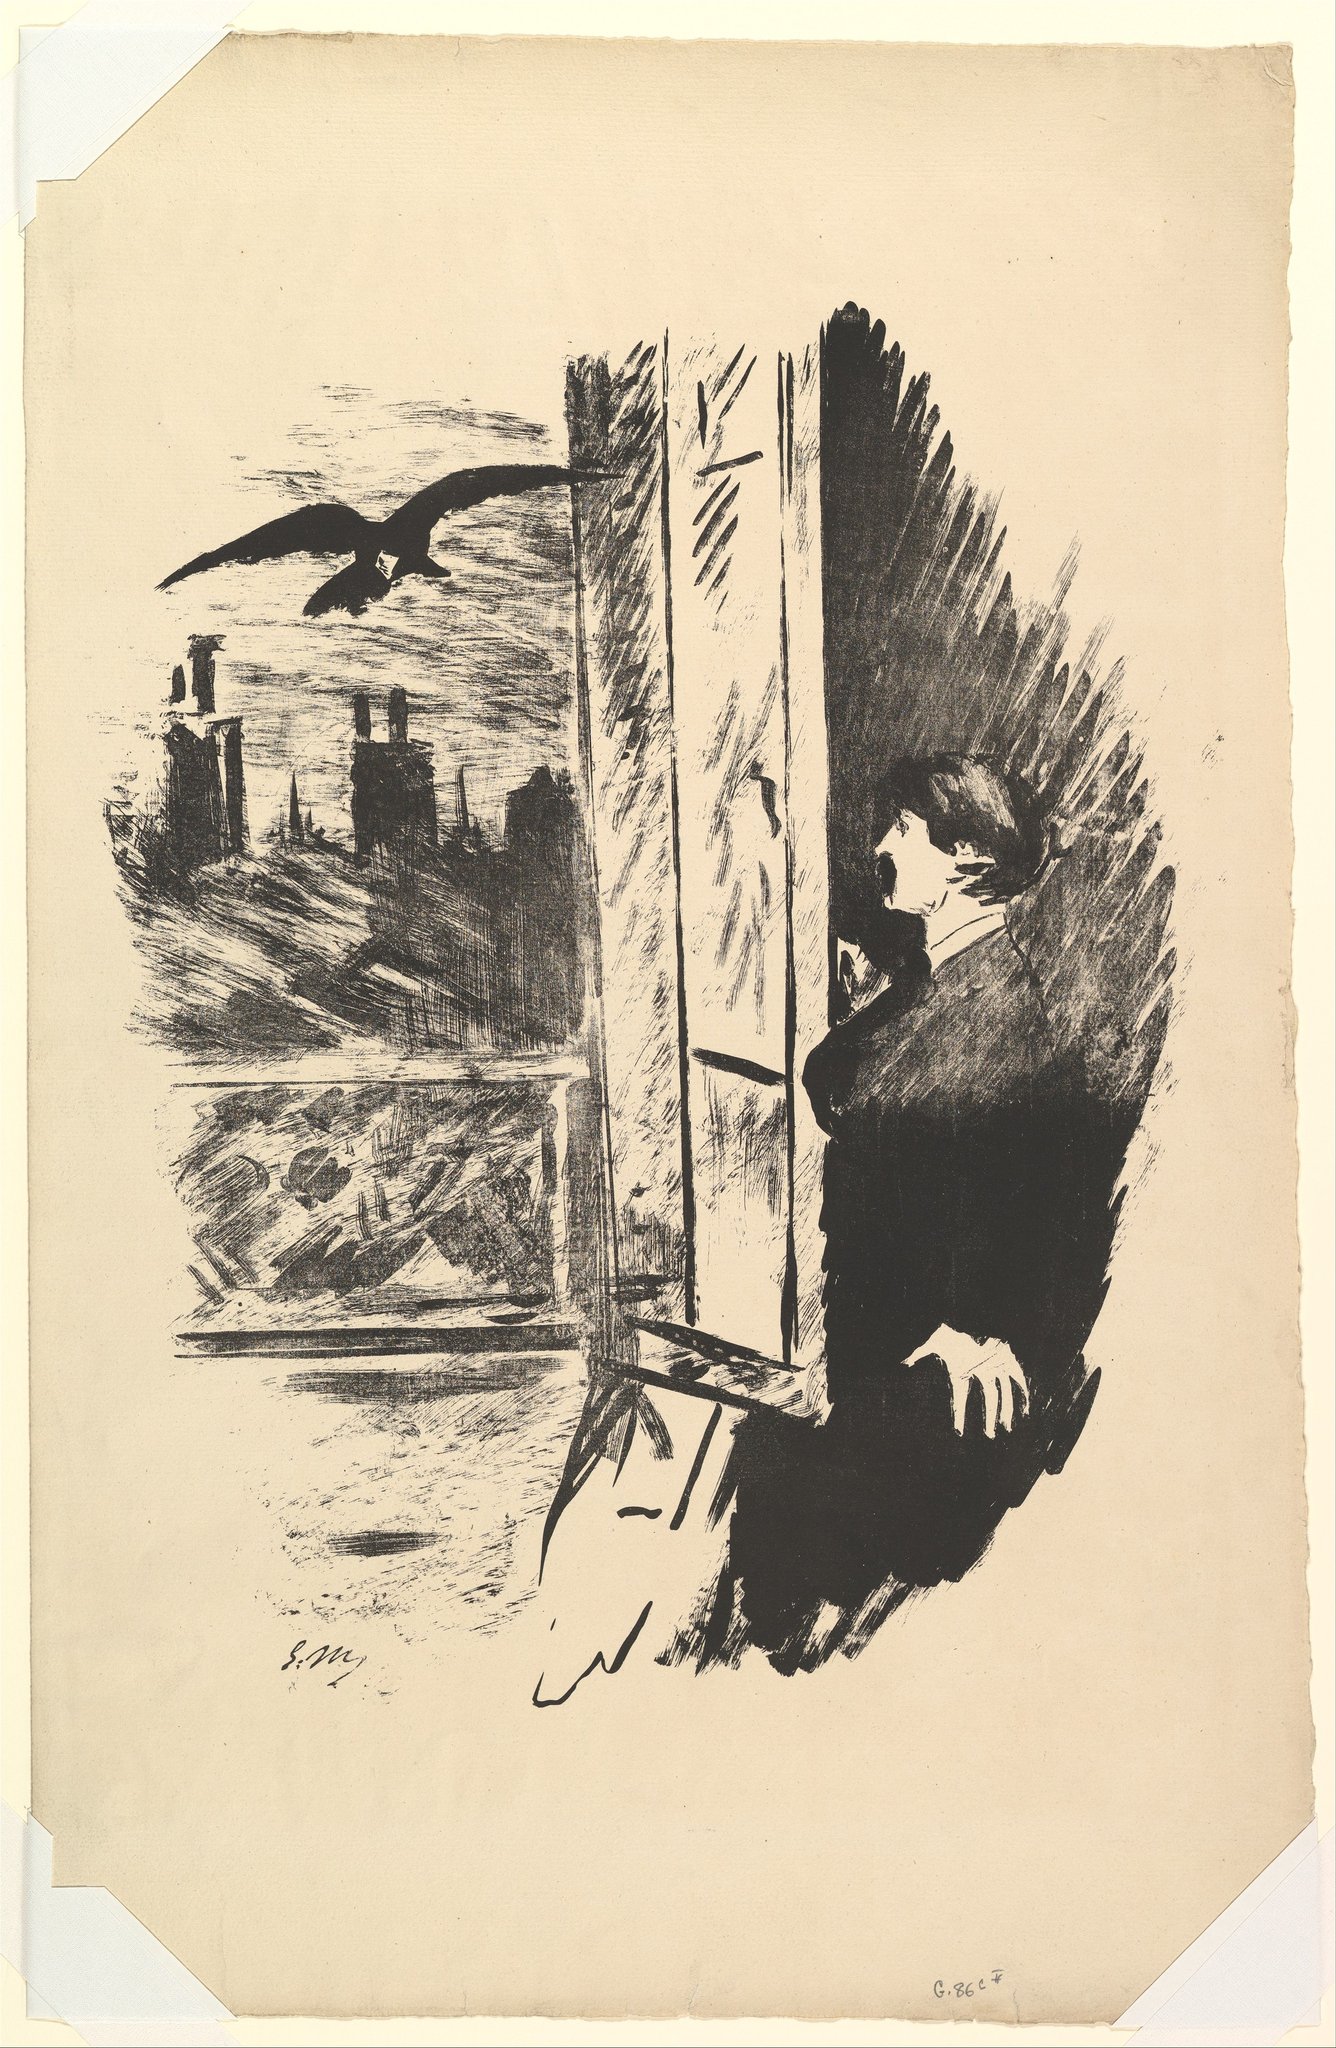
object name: print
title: Open Here I Flung the Shutter, from "The Raven" by Edgar Allan Poe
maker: édouard manet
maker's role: artist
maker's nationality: french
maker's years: 1832-1883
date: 1875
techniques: lithography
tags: birds,windows,men